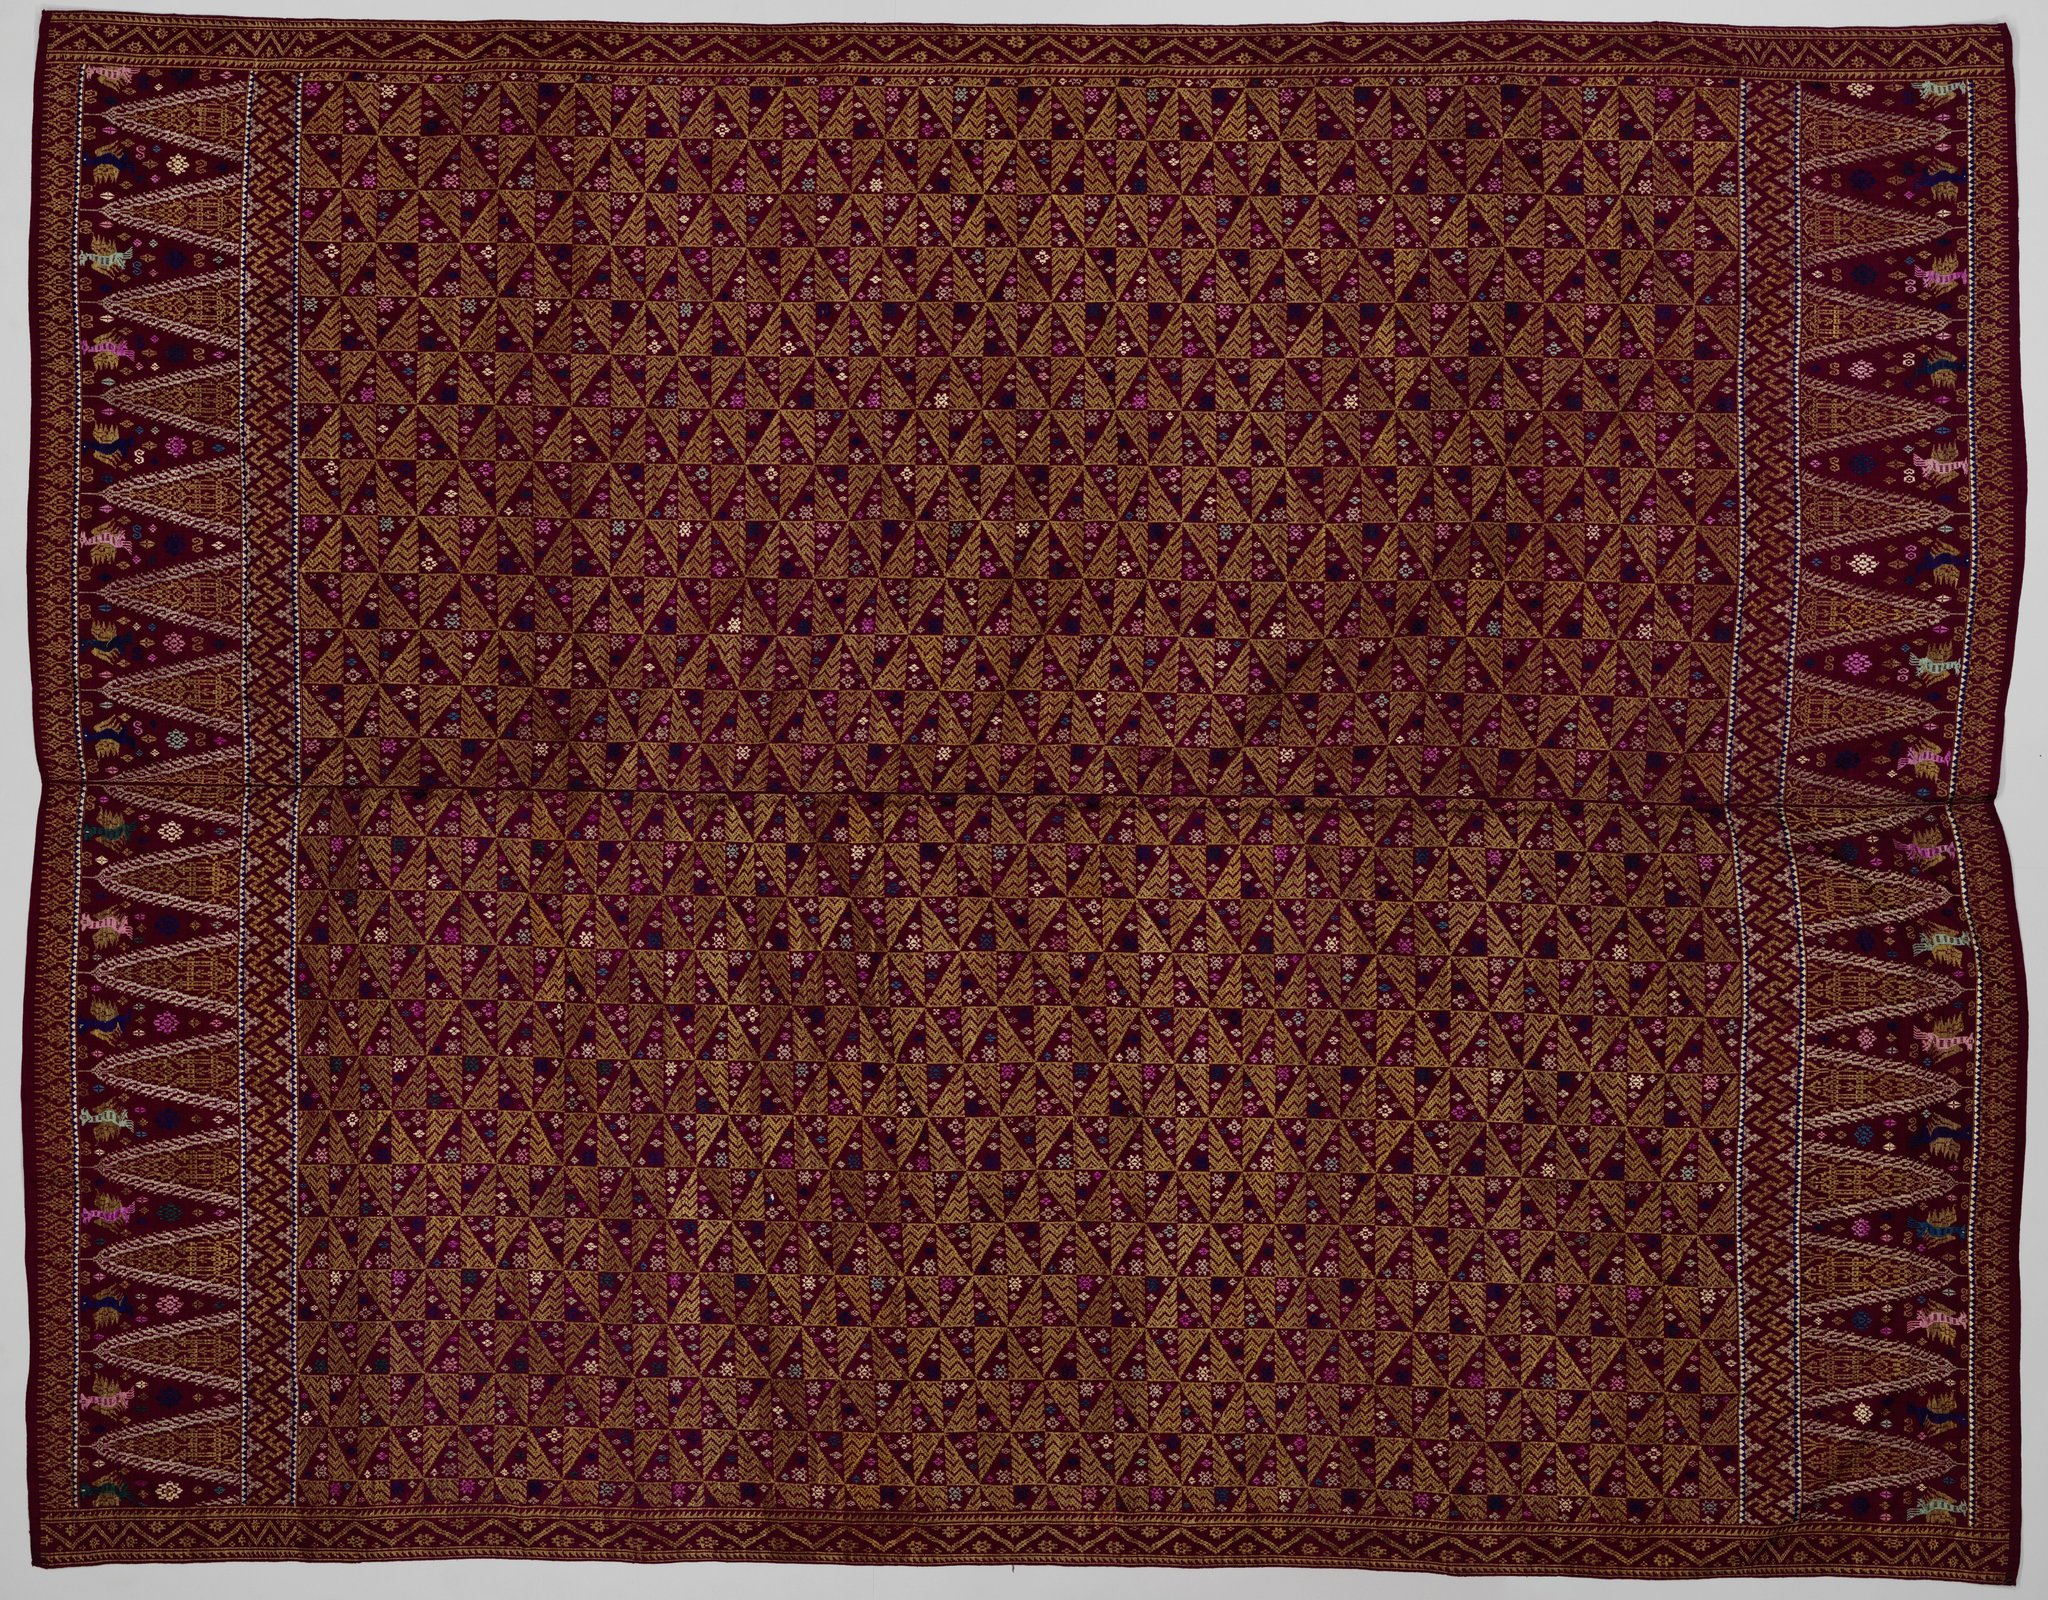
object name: heupdoek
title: Kain songket, saput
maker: Anonymous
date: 1900-1949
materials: silk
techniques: weave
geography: bali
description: Heupdoek met molenwiekmotief en vogelfiguren.